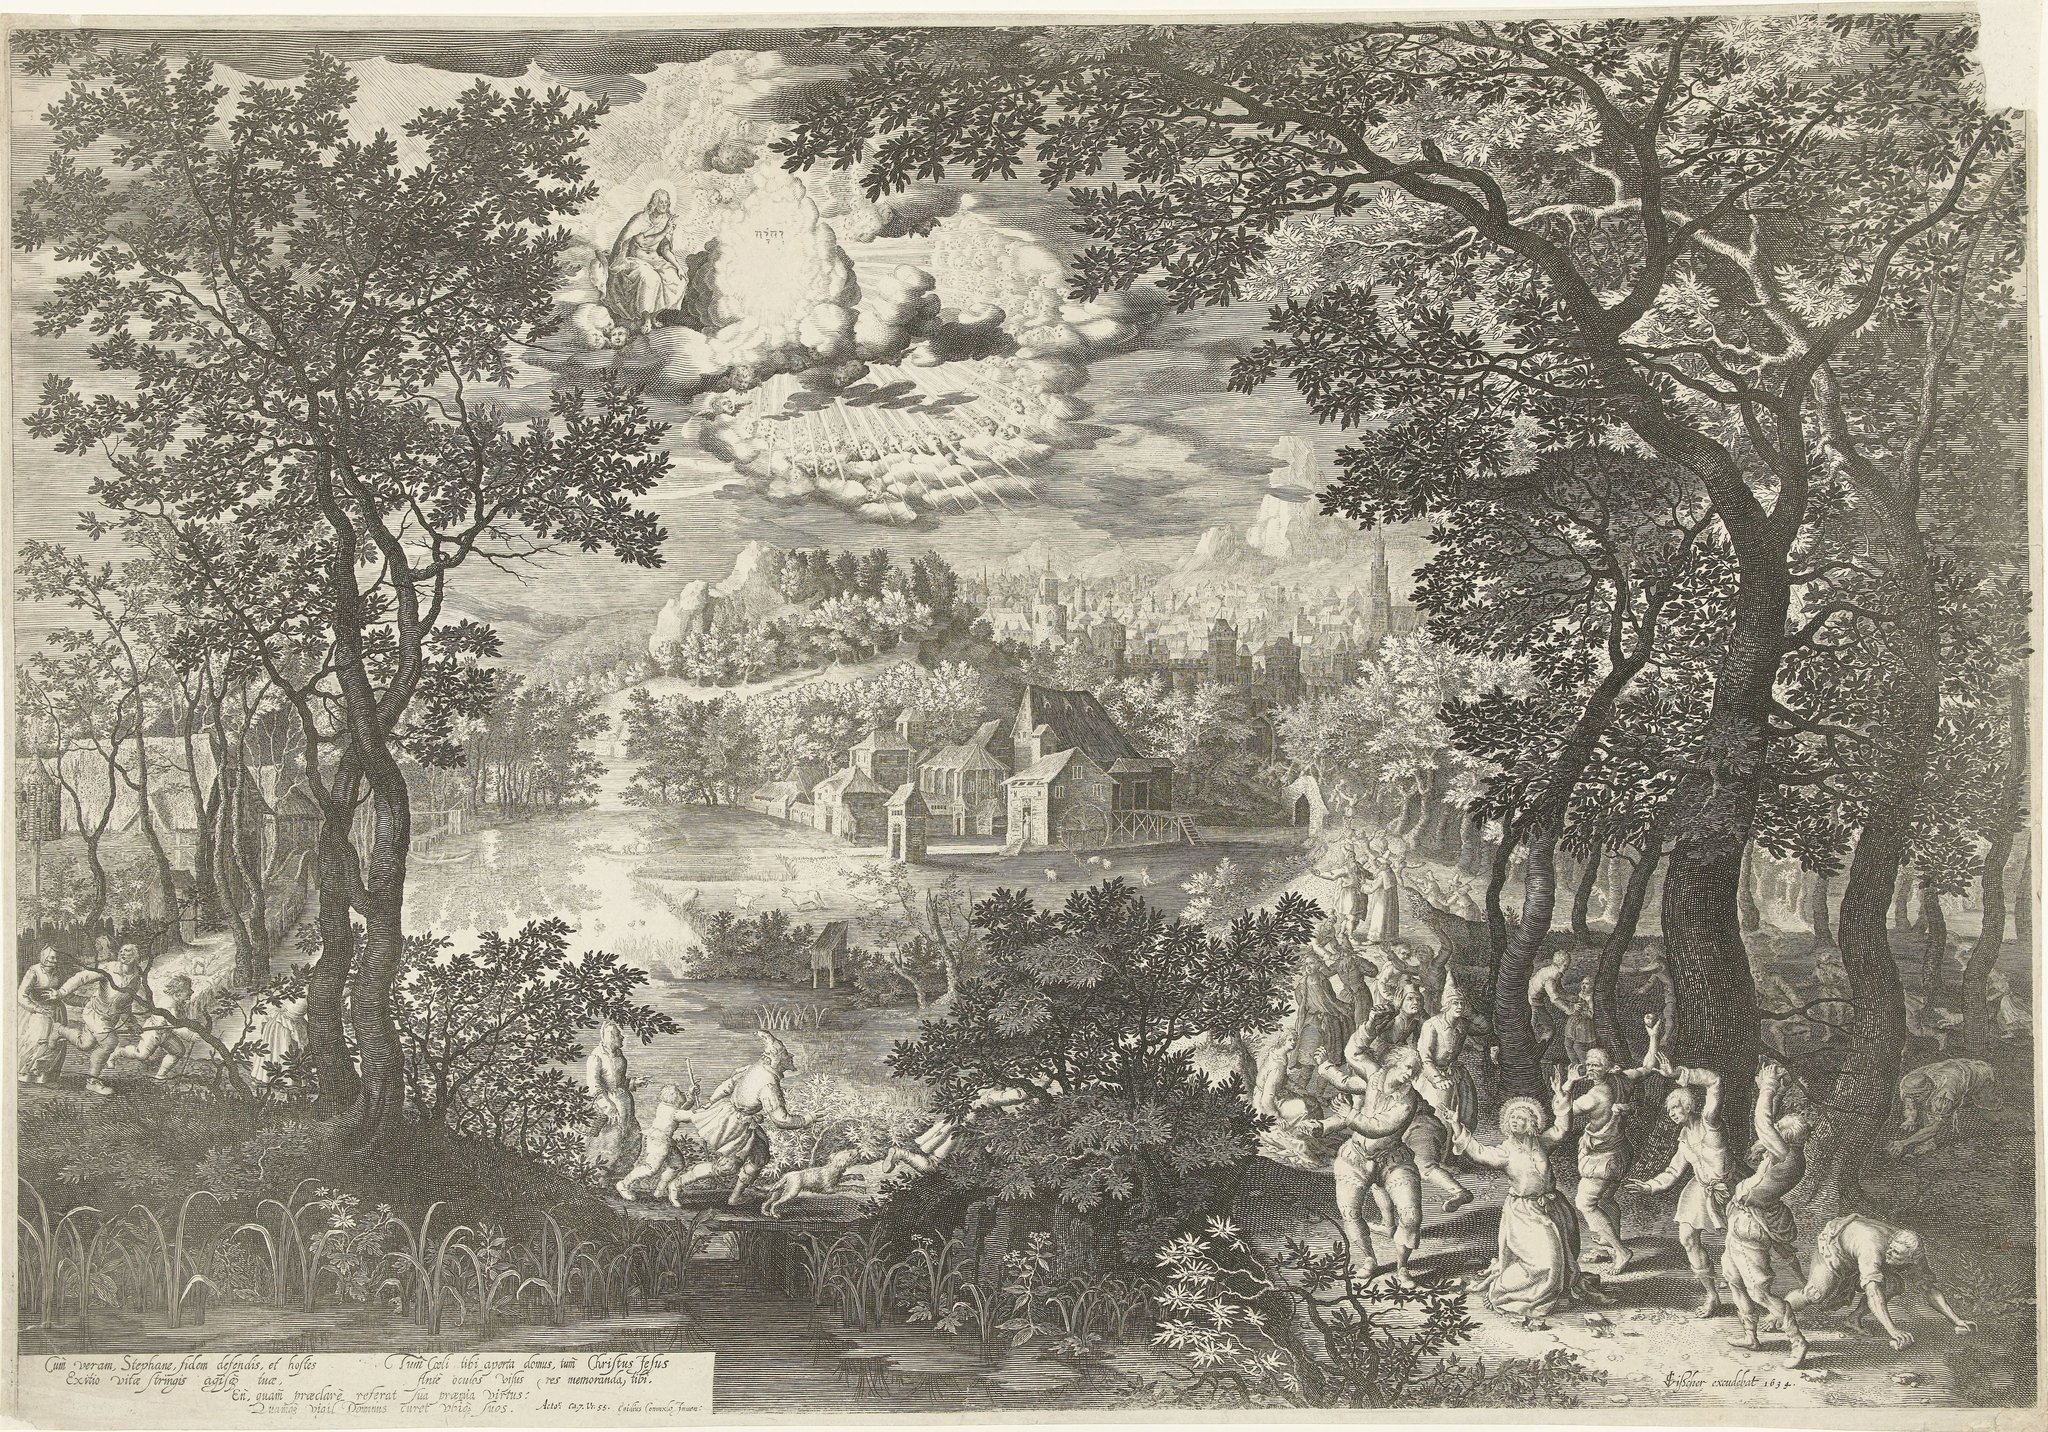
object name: print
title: Landschap met martelaarschap van de heilige Stefanus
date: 1590-1633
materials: paper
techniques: engraving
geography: netherlands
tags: the stoning of stephen; the witnesses lay down their clothes at saul's feet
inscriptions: collector's mark: Lugt 2228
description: Landschap met martelaarschap van de heilige Stefanus waarbij hij gestenigd wordt door een menigte die hem achtervolgt. Linksonder bijbeltekst in zes regels Latijn uit Handelingen 7:55.